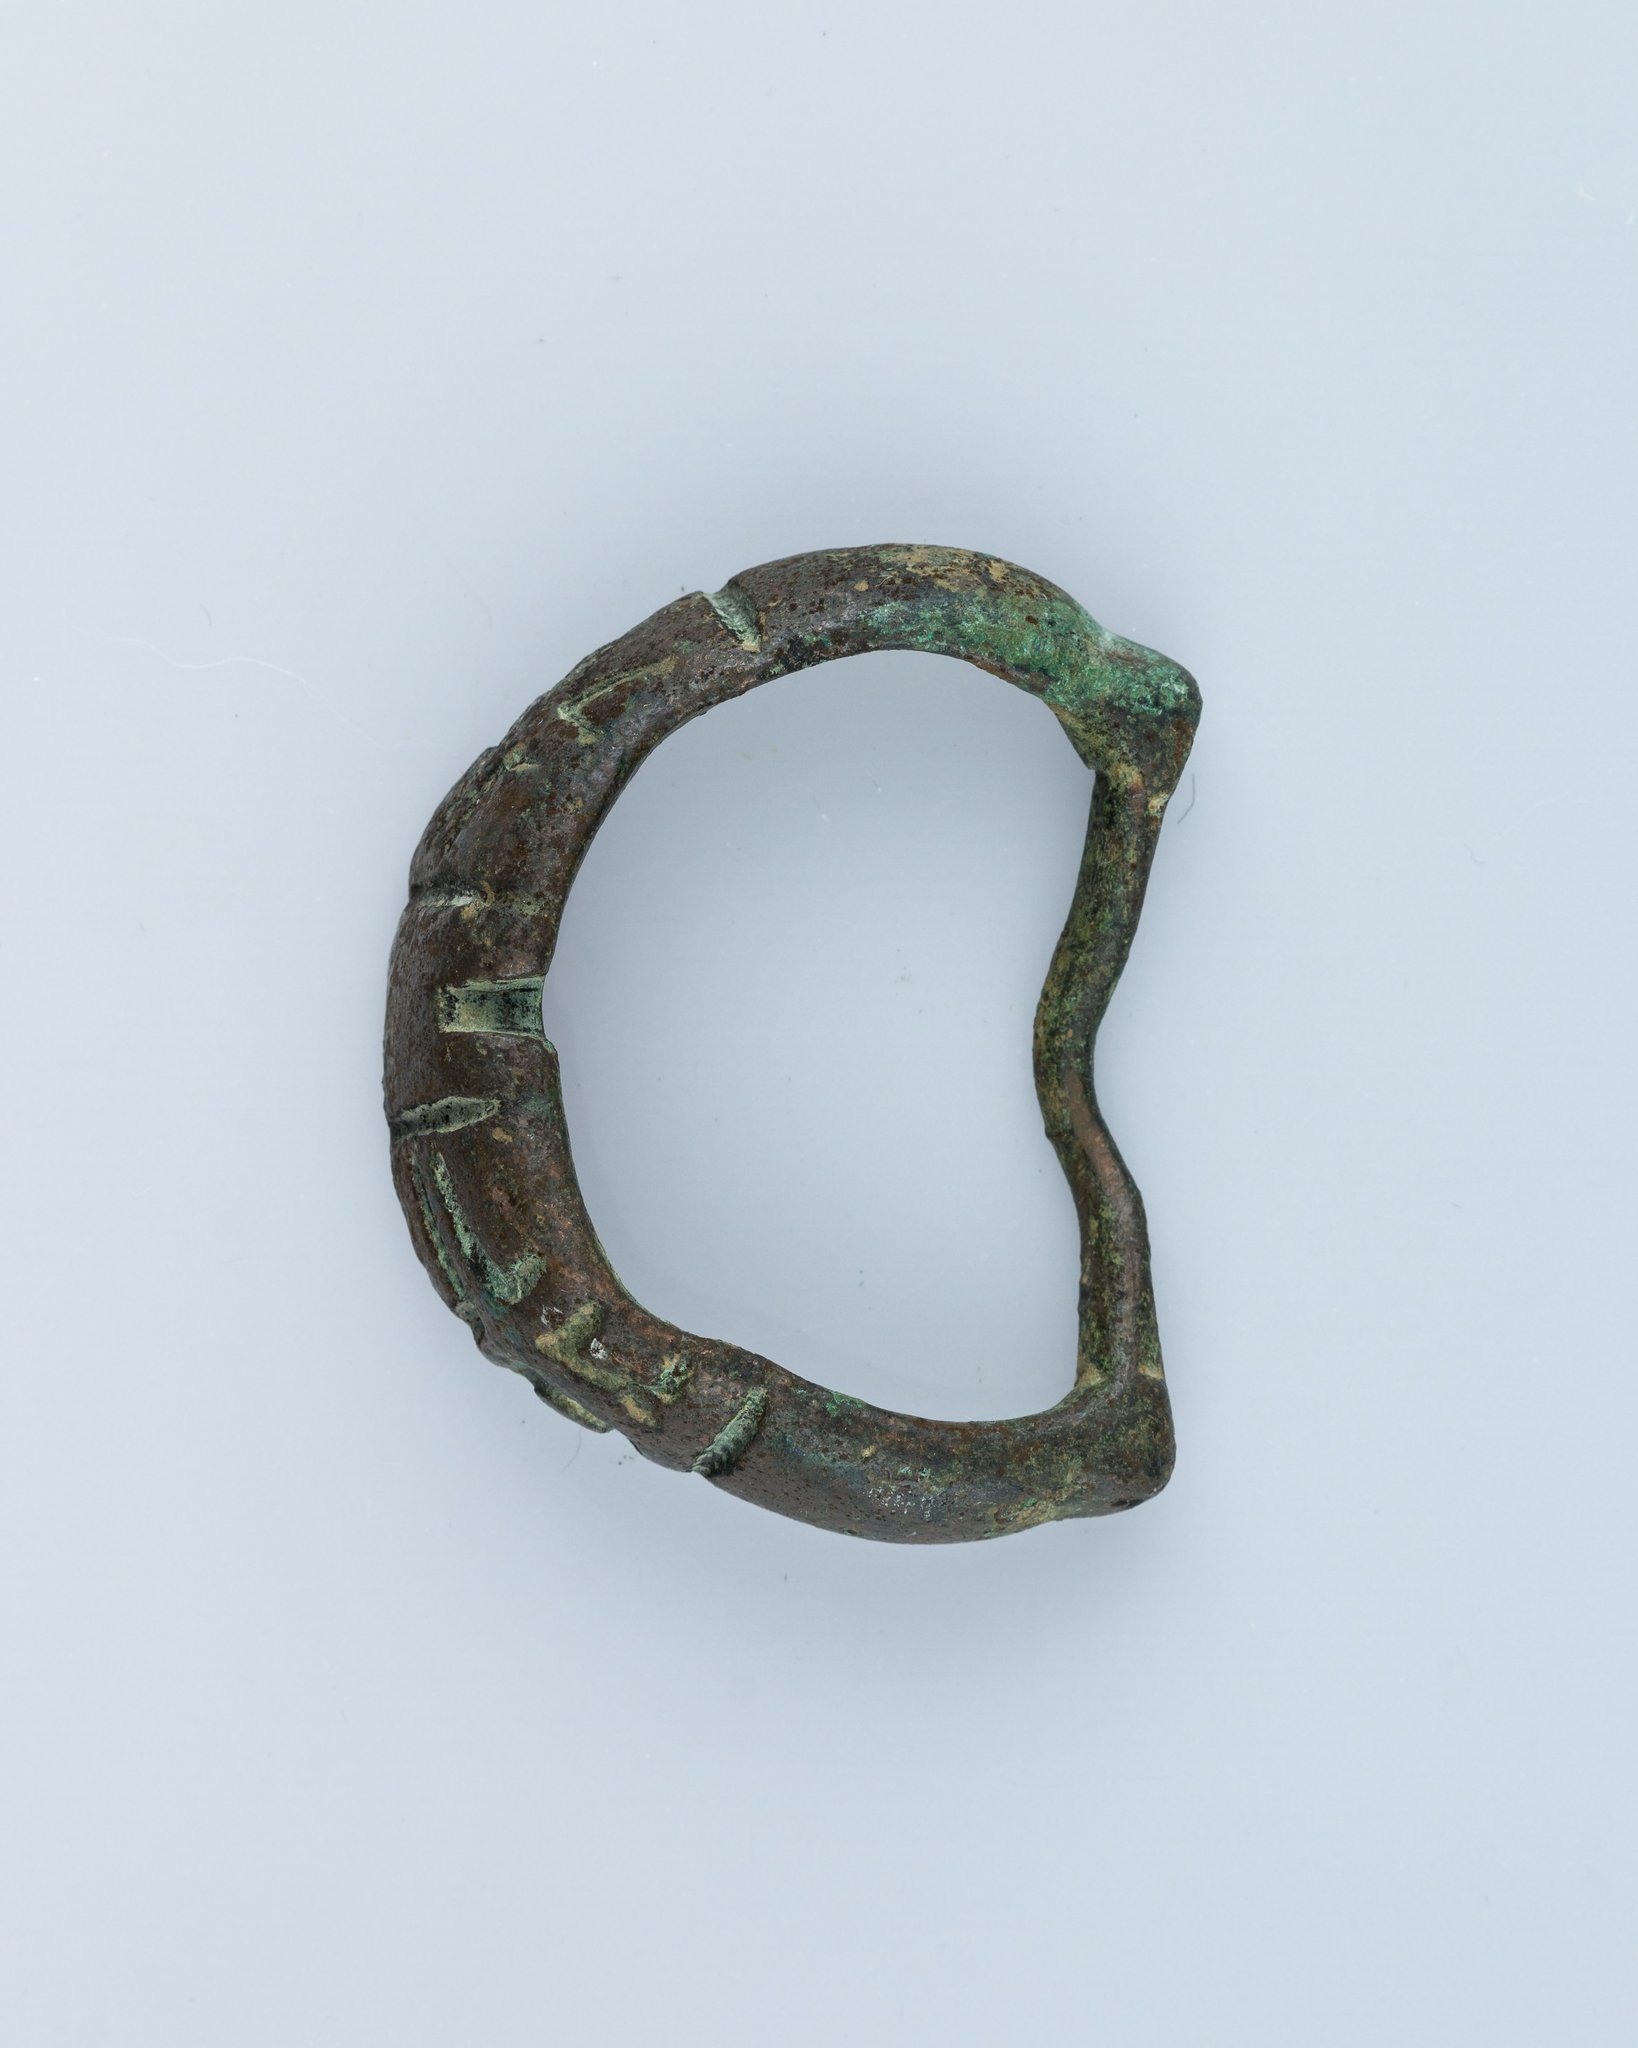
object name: buckle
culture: ibero-roman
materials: bronze, patina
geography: spain or portugal